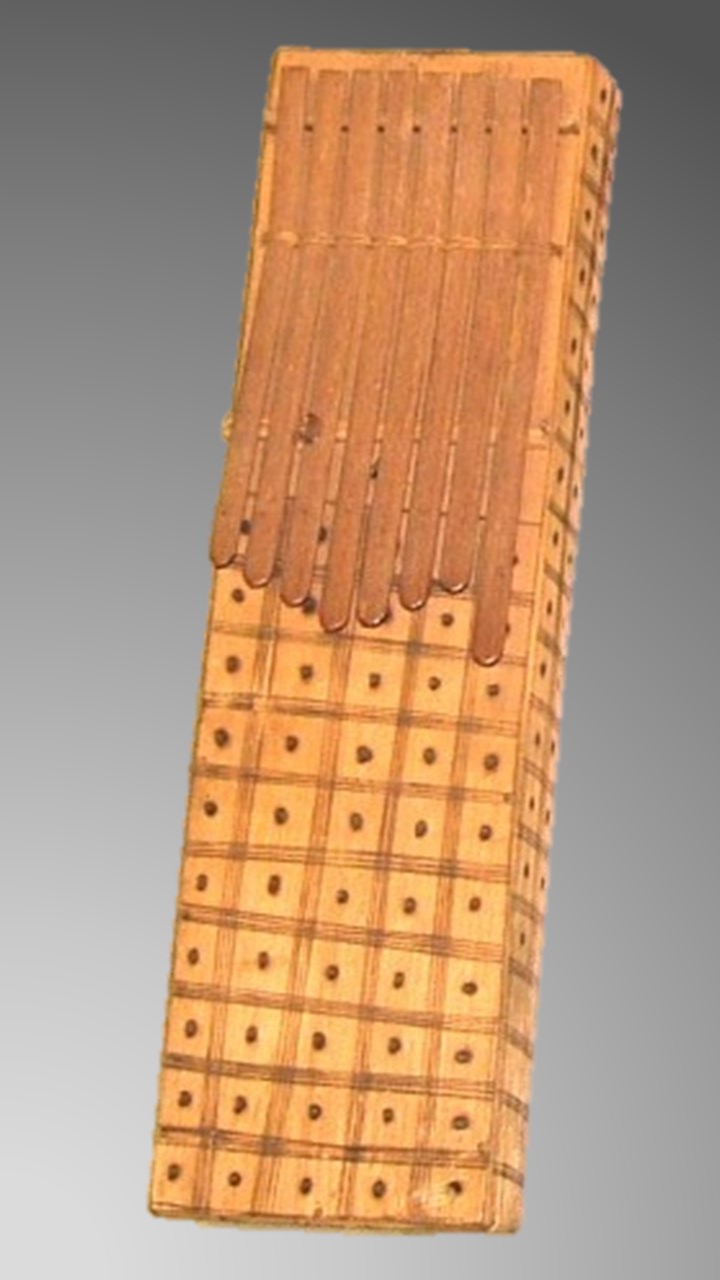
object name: zanze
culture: nigerian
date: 1867-1900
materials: rattan, wood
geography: nigeria